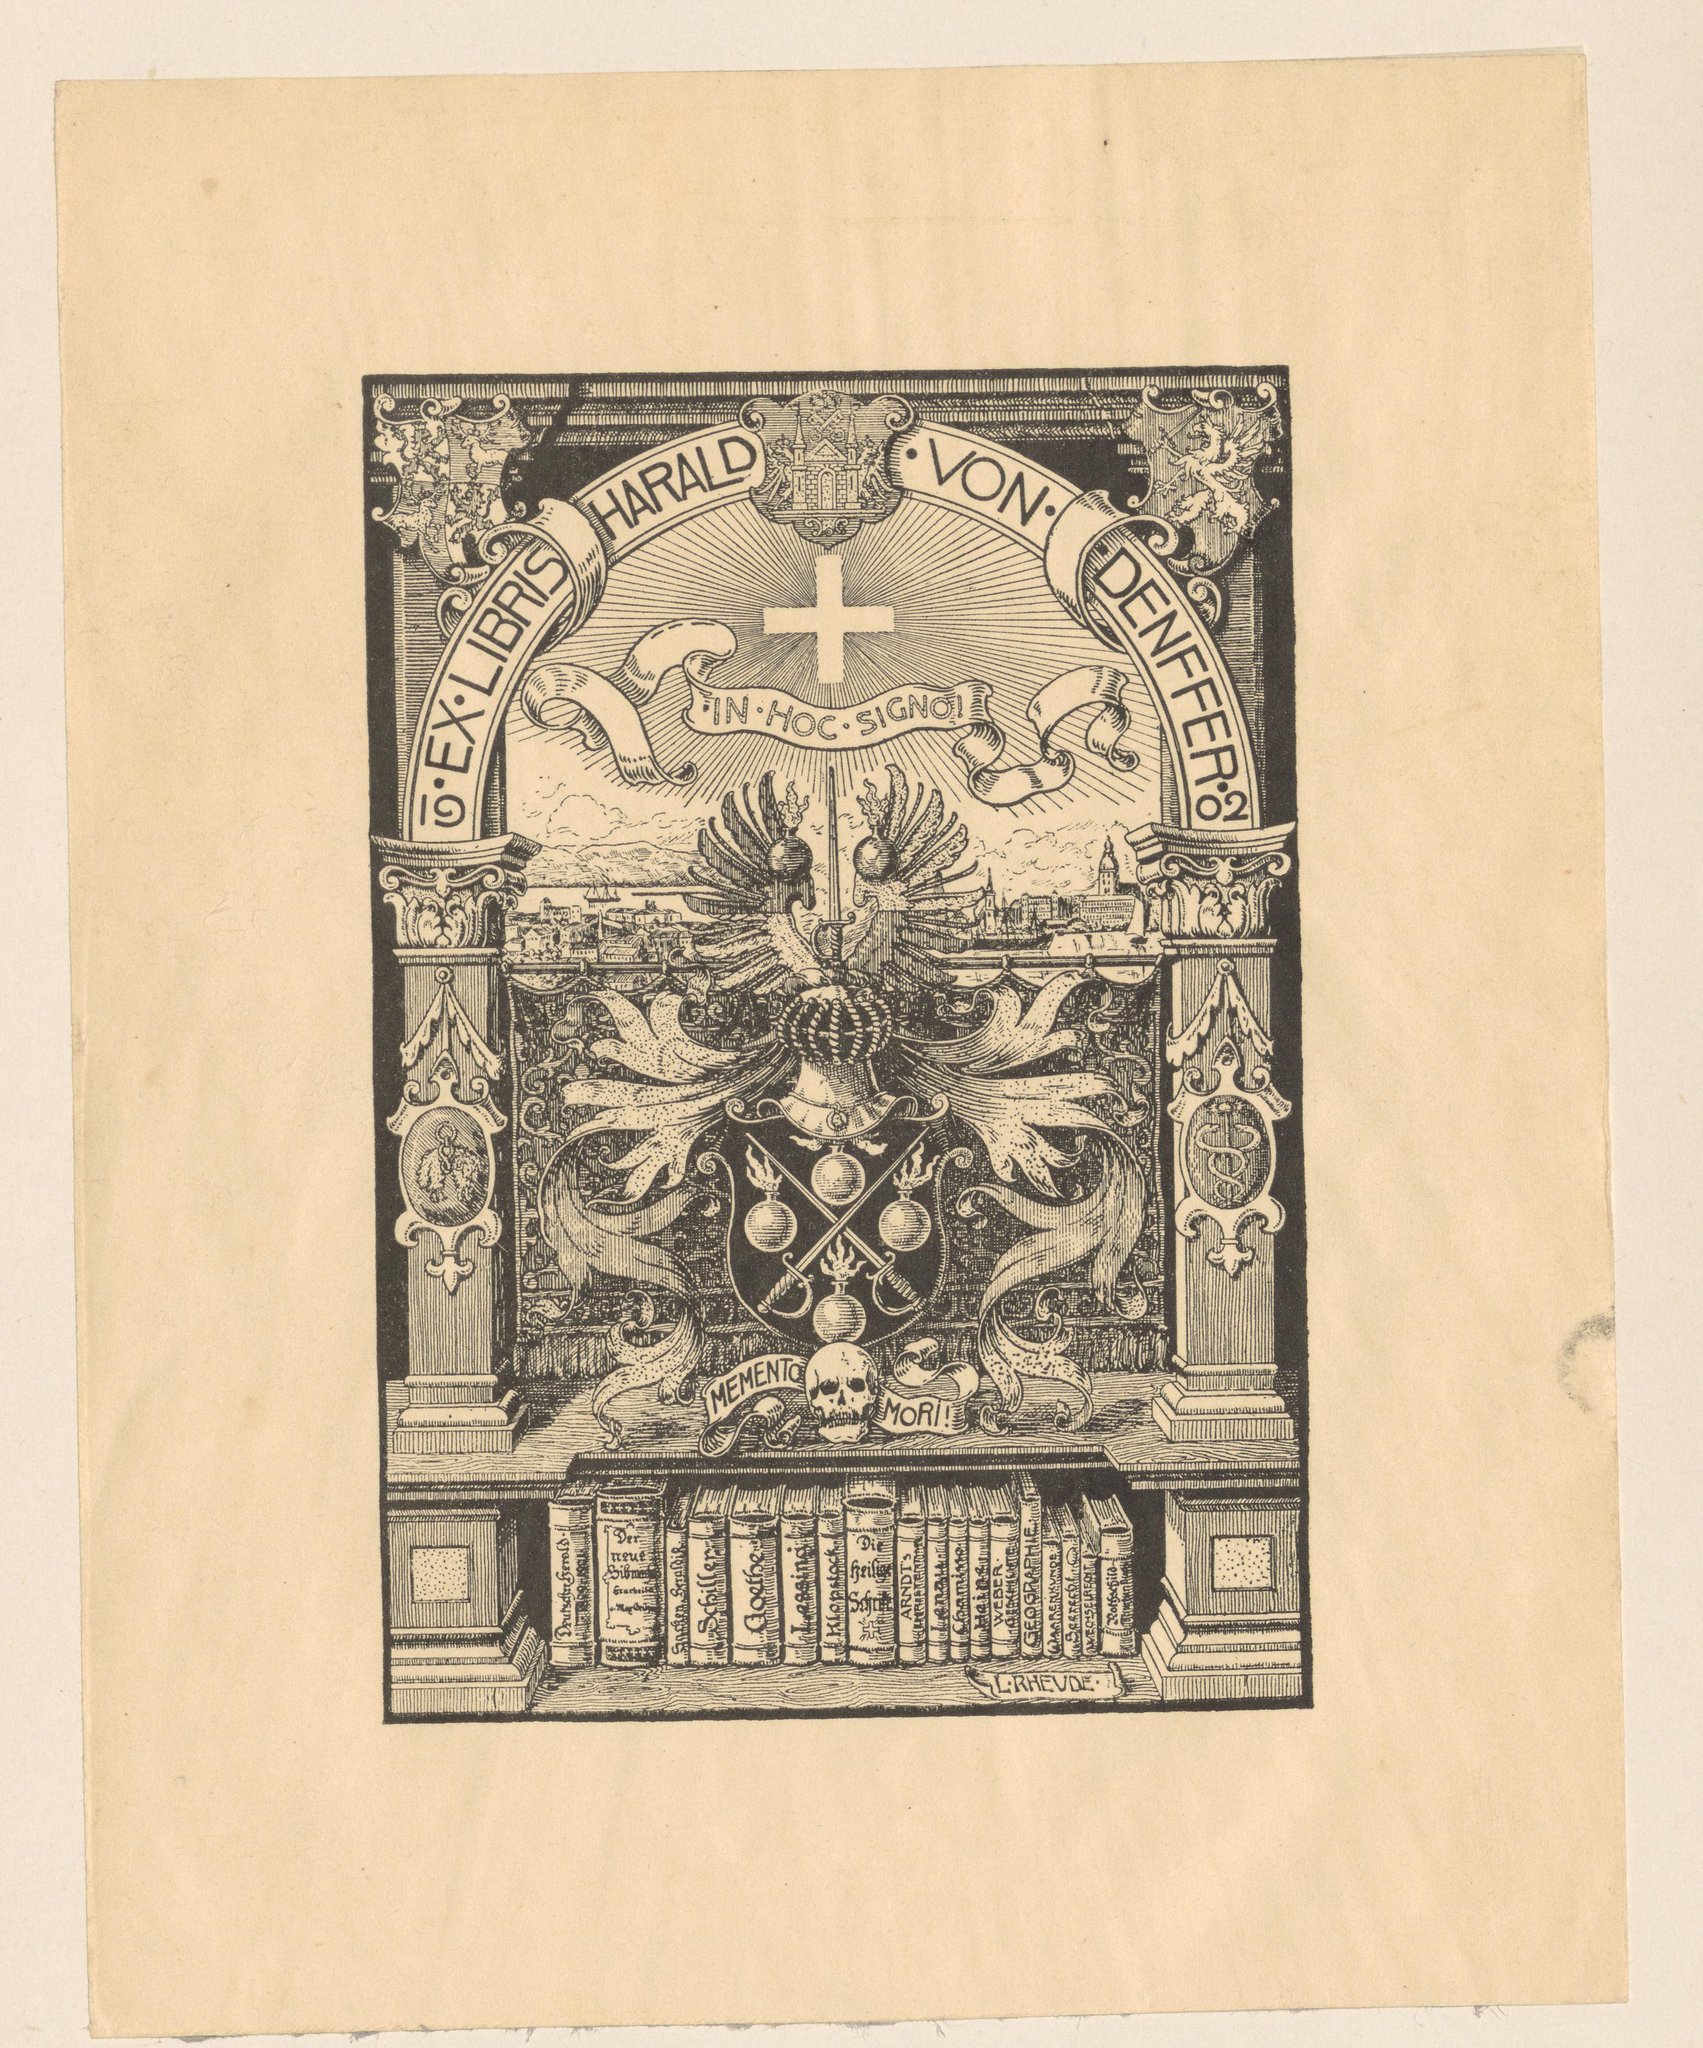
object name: bookplate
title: Ex libris van Harald von Denffer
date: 1902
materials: paper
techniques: printing block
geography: germany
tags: bookshelves, (human) skull, the cross ~ symbols of christ, book, prospect of city, town panorama, silhouette of city, armorial bearing, heraldry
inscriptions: date